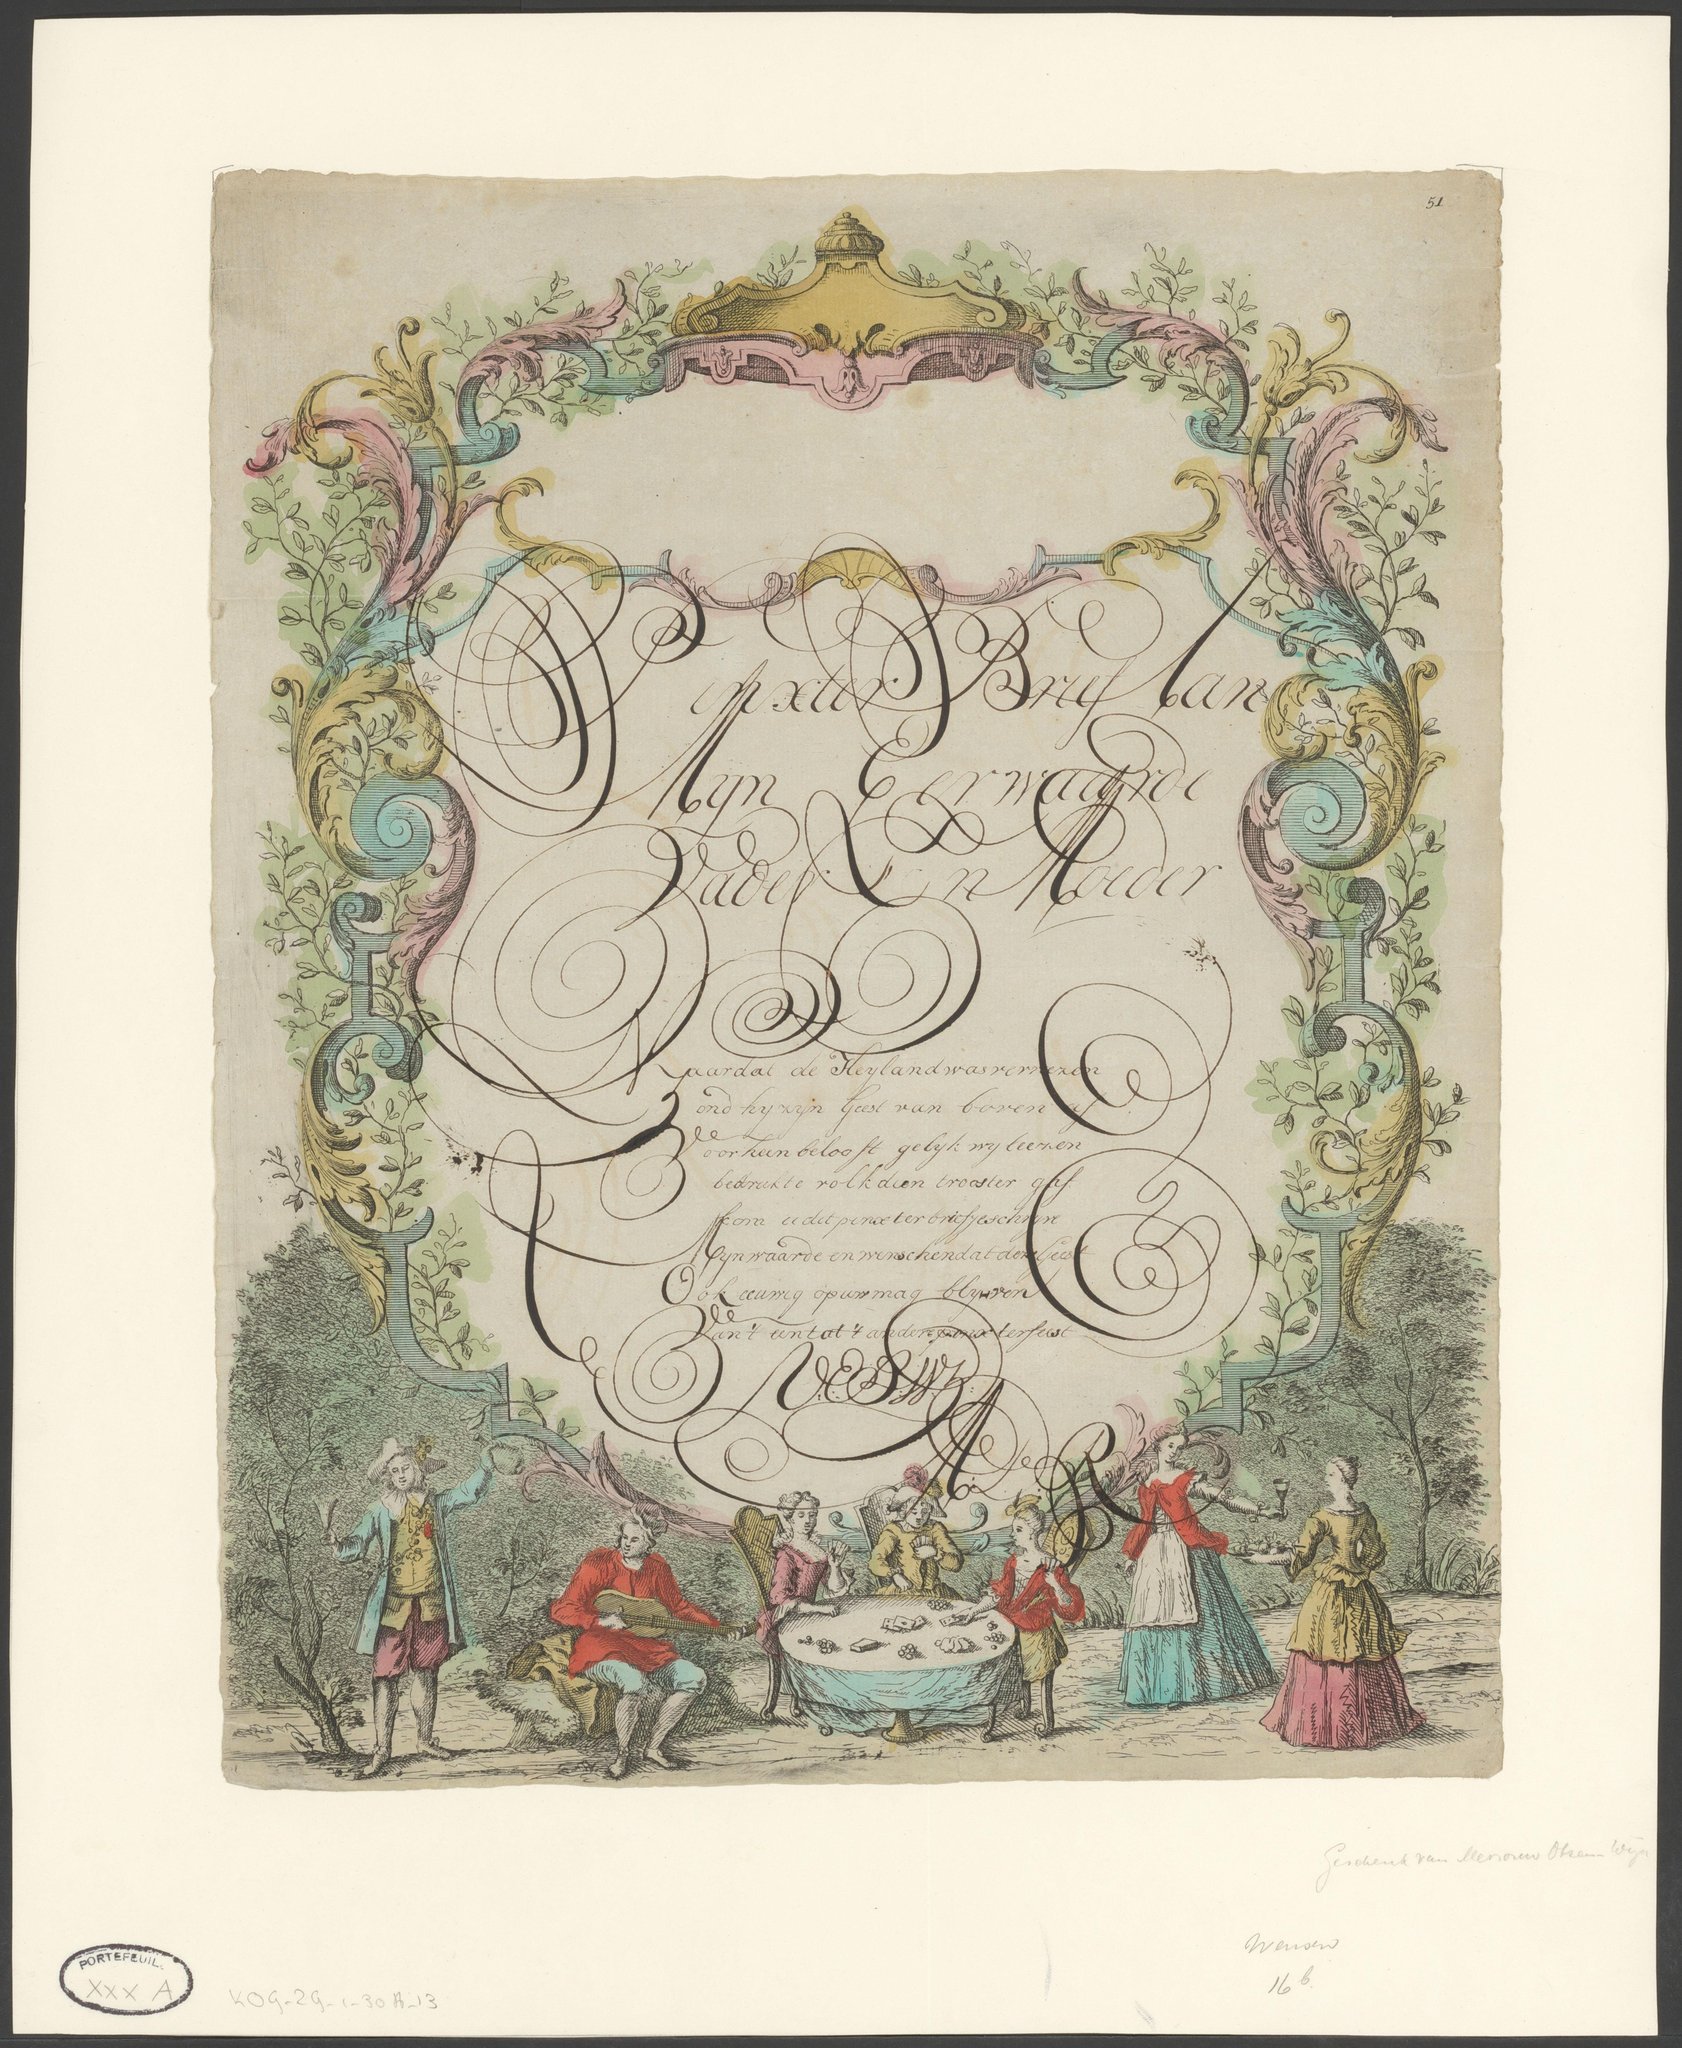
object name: wensbrief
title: Pinksterbrief geschreven door een kind ADR, zonder jaartal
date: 1800-1825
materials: ink, paper, watercolor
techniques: engraving, etching, hand coloring, writing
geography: netherlands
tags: pentecost, whitsunday, calendar festivals, non-liturgical celebrations of days belonging to the ecclesiastical calendar, banquet of elegant company - cc - out of doors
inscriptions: collector's mark, collector's mark: Lugt 1641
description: Pinksterbrief geschreven door een kind met de initialen ADR, zonder jaartal. Gericht aan de ouders. Handgeschreven vers binnen een voorgedrukte omlijsting met een elegant gezelschap dat zich in een tuin vermaakt met muziek, drinken en kaartspel. Rechtsboven genummerd: 51. Onderwerpsrubrieken binnen de Atlas Zeden en Gewoonten: Nieuwjaars- en kermiswenschen.